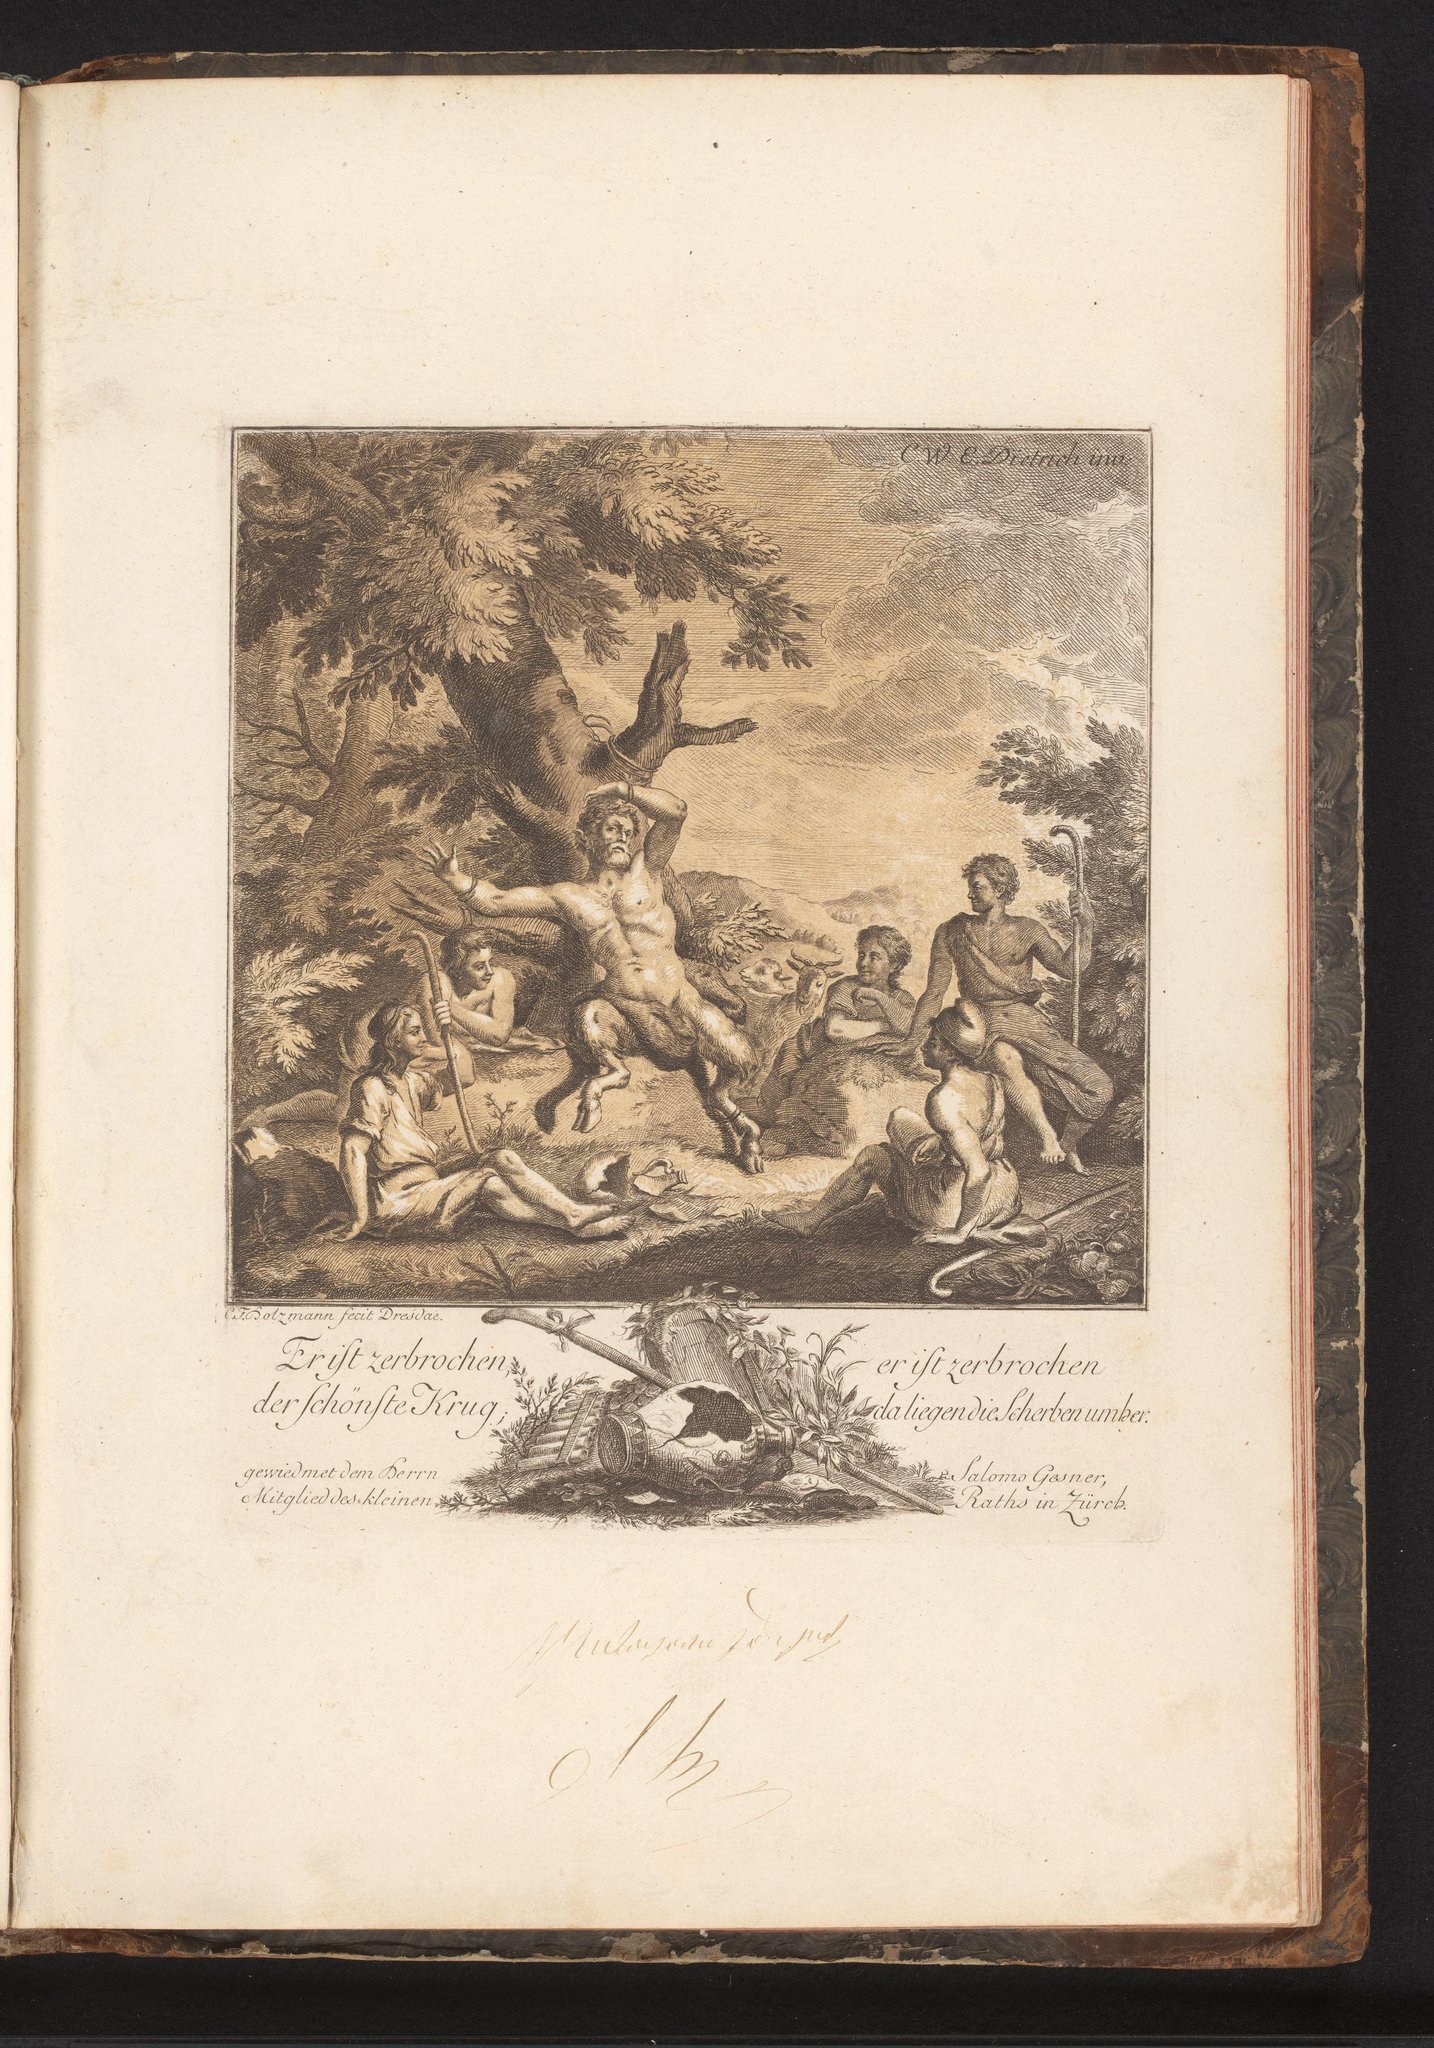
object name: print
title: Silenus gevangen door de Frygische dienaars onder koning Midas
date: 1750-1811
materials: paper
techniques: etching, intaglio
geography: dresden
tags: silenus captured by the phrygian farmers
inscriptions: collector's mark: Lugt 2228, annotation, collector's mark: Lugt 2760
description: Tekst in het Duits in de ondermarge. Prent maakt deel uit van een album.